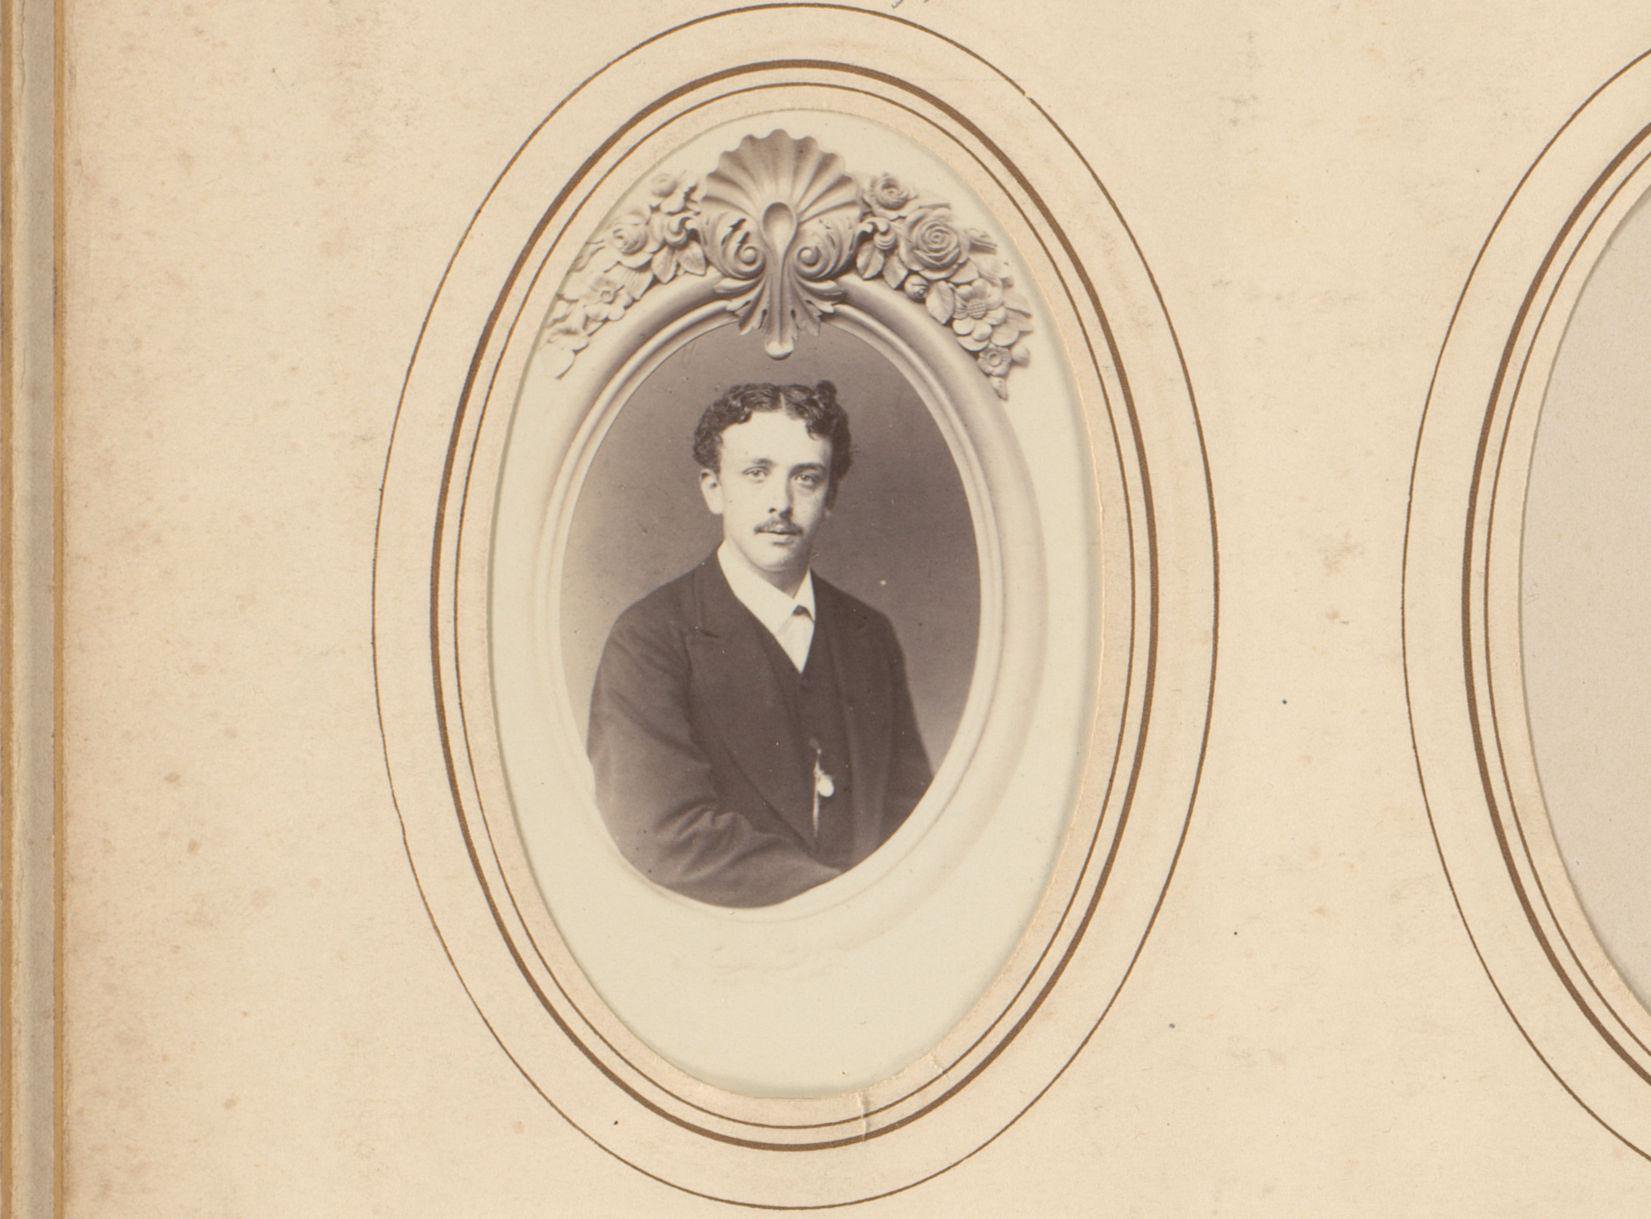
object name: album leaf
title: Portret van onbekende man in ovale lijst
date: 1870-1890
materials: cardboard, photographic support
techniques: albumen print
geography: germany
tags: photography, adult man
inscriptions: inscription: ‘Niepce / Daguerre / Talbot / Kaufmann & Kesseler / Bad Creuznach. / Hinter dem Curhause.’